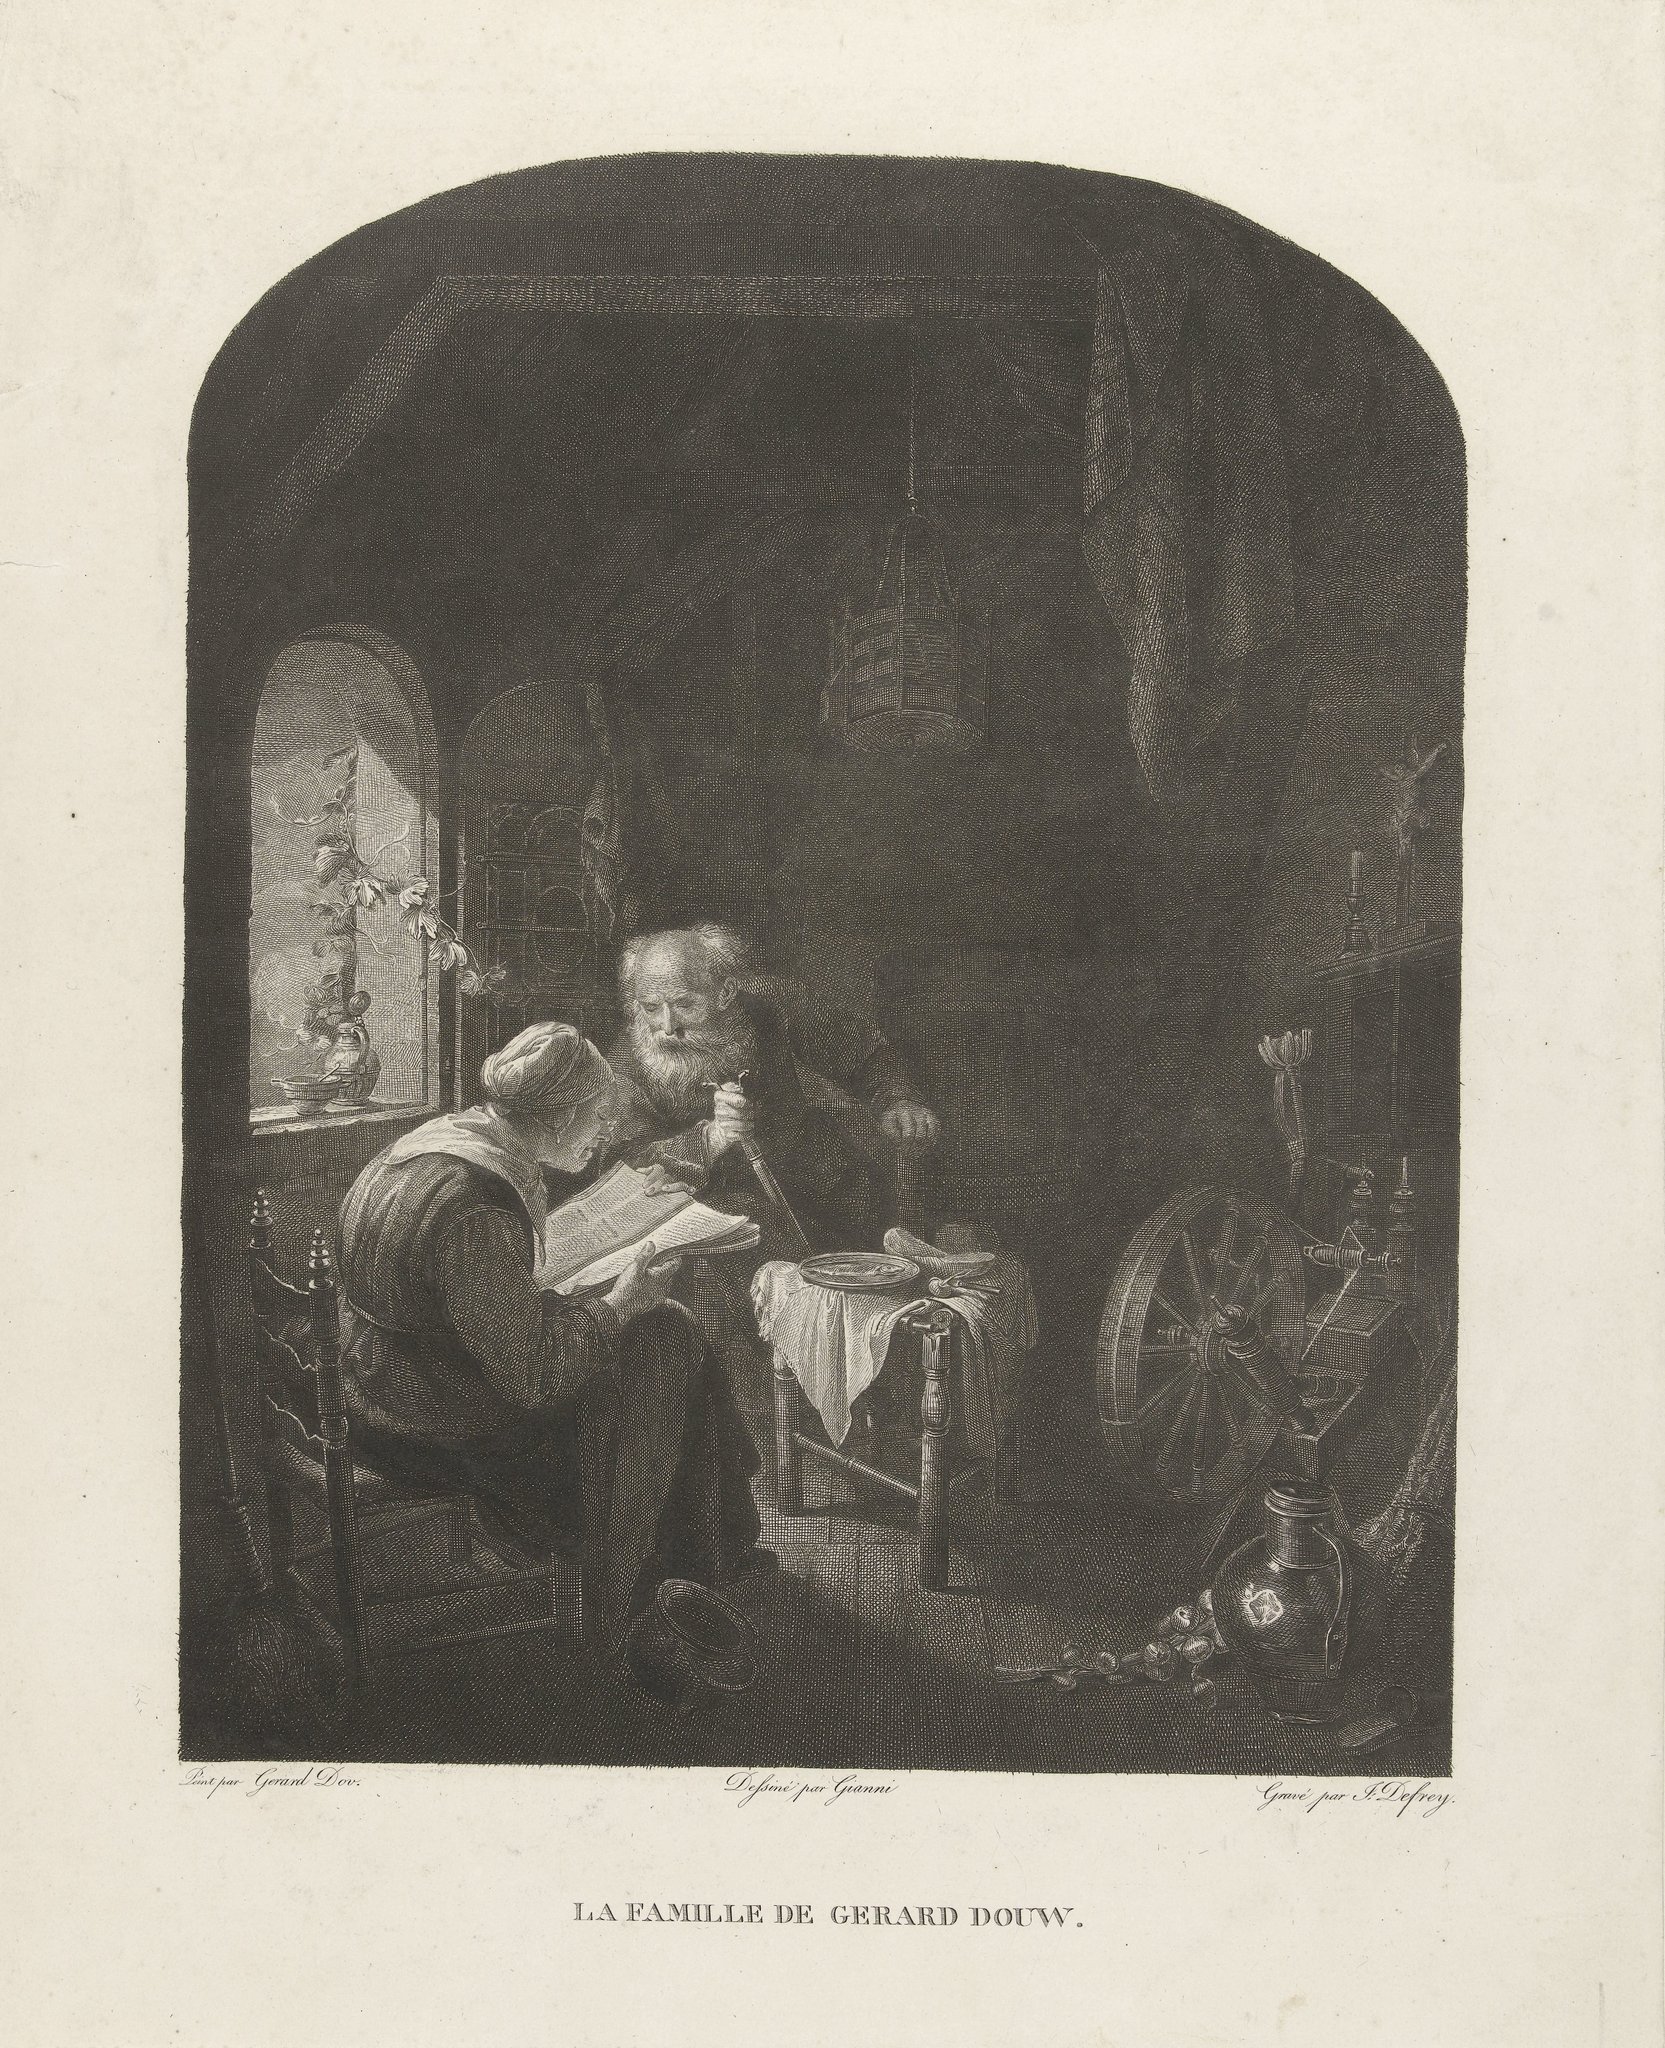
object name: print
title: Ouder echtpaar leest de bijbel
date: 1780-1834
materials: paper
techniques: etching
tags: reading the bible or other religious books, the marriage of tobit and anna (tobit 1:1-9)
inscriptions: collector's mark: Lugt 2228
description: In een schaars verlichte kamer leest een oude vrouw een tegenover haar gezeten oude man voor uit de Bijbel. Geboeid door het verhaal buigt de oude man al leunend op zijn stok wat naar voren in zijn stoel. Rechts in de kamer staat een spinnewiel. De voorstelling is ook wel bekend als Anna en Tobit.